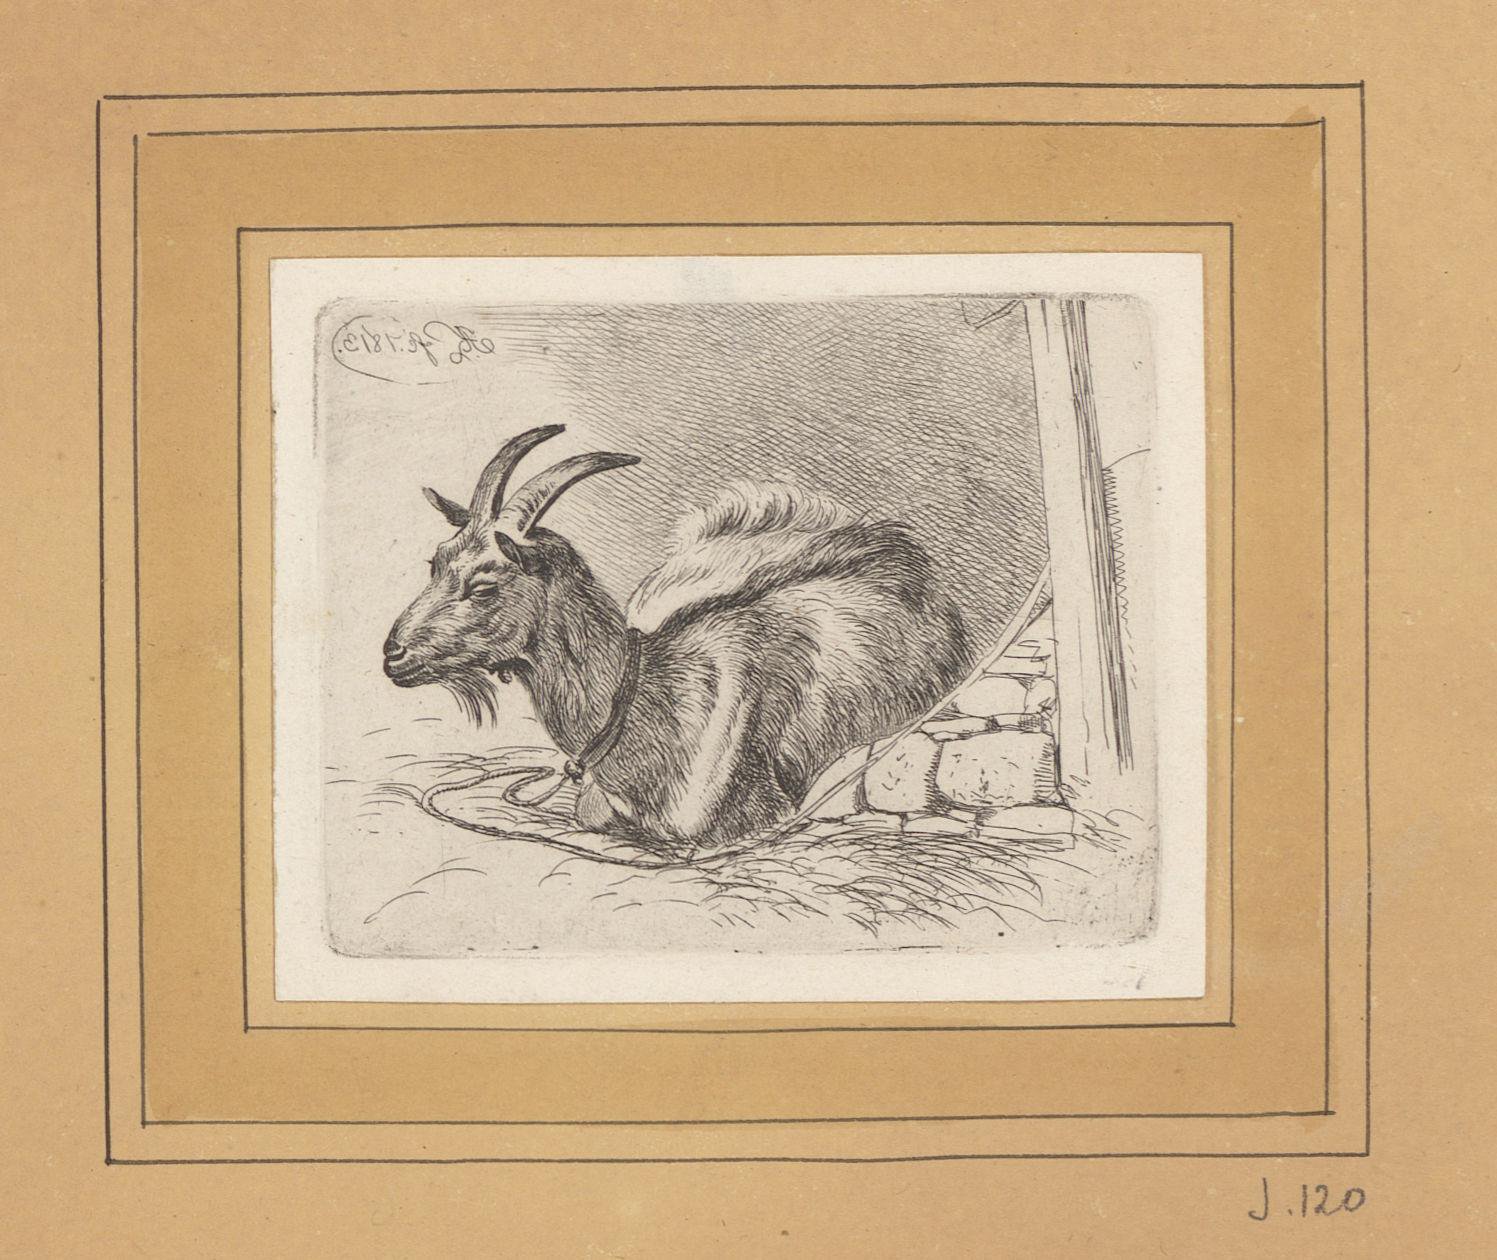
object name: print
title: Liggende geit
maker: johann adam klein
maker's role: draughtsman, print maker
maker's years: 1792-1875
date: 1813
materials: paper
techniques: etching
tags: goat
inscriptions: collector's mark: Lugt 2760, collector's mark: Lugt 2228